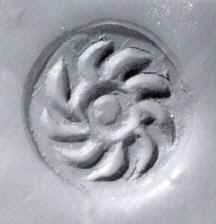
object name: stamp seal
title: Carinated lentoid seal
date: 3500-3000 BCE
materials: mineral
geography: iran or mesopotamia